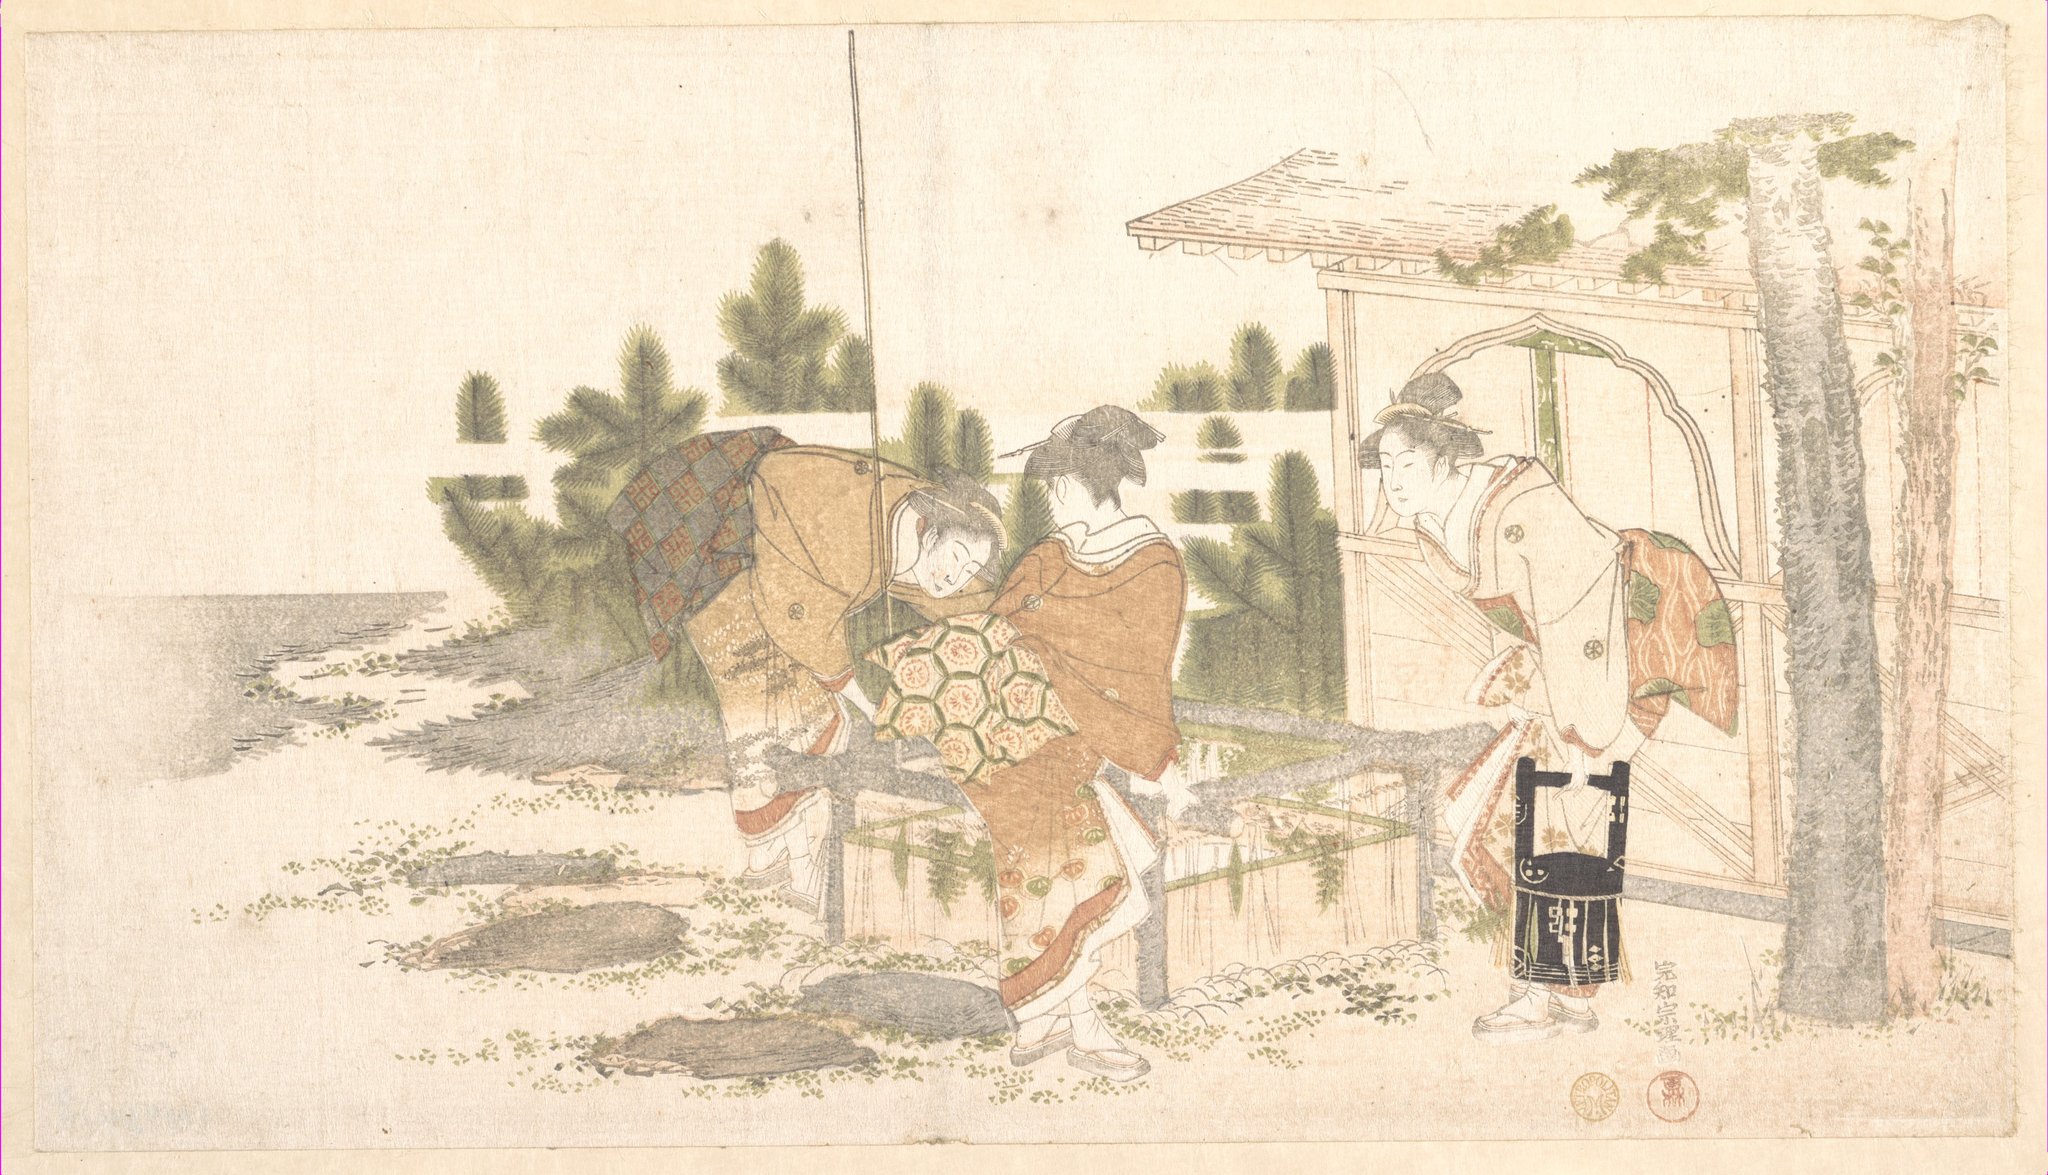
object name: print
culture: japanese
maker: katsushika hokusai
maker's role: artist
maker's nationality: japanese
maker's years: 1760-1849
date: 1800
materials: ink, paper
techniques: surimono, woodblock print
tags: houses,women,working